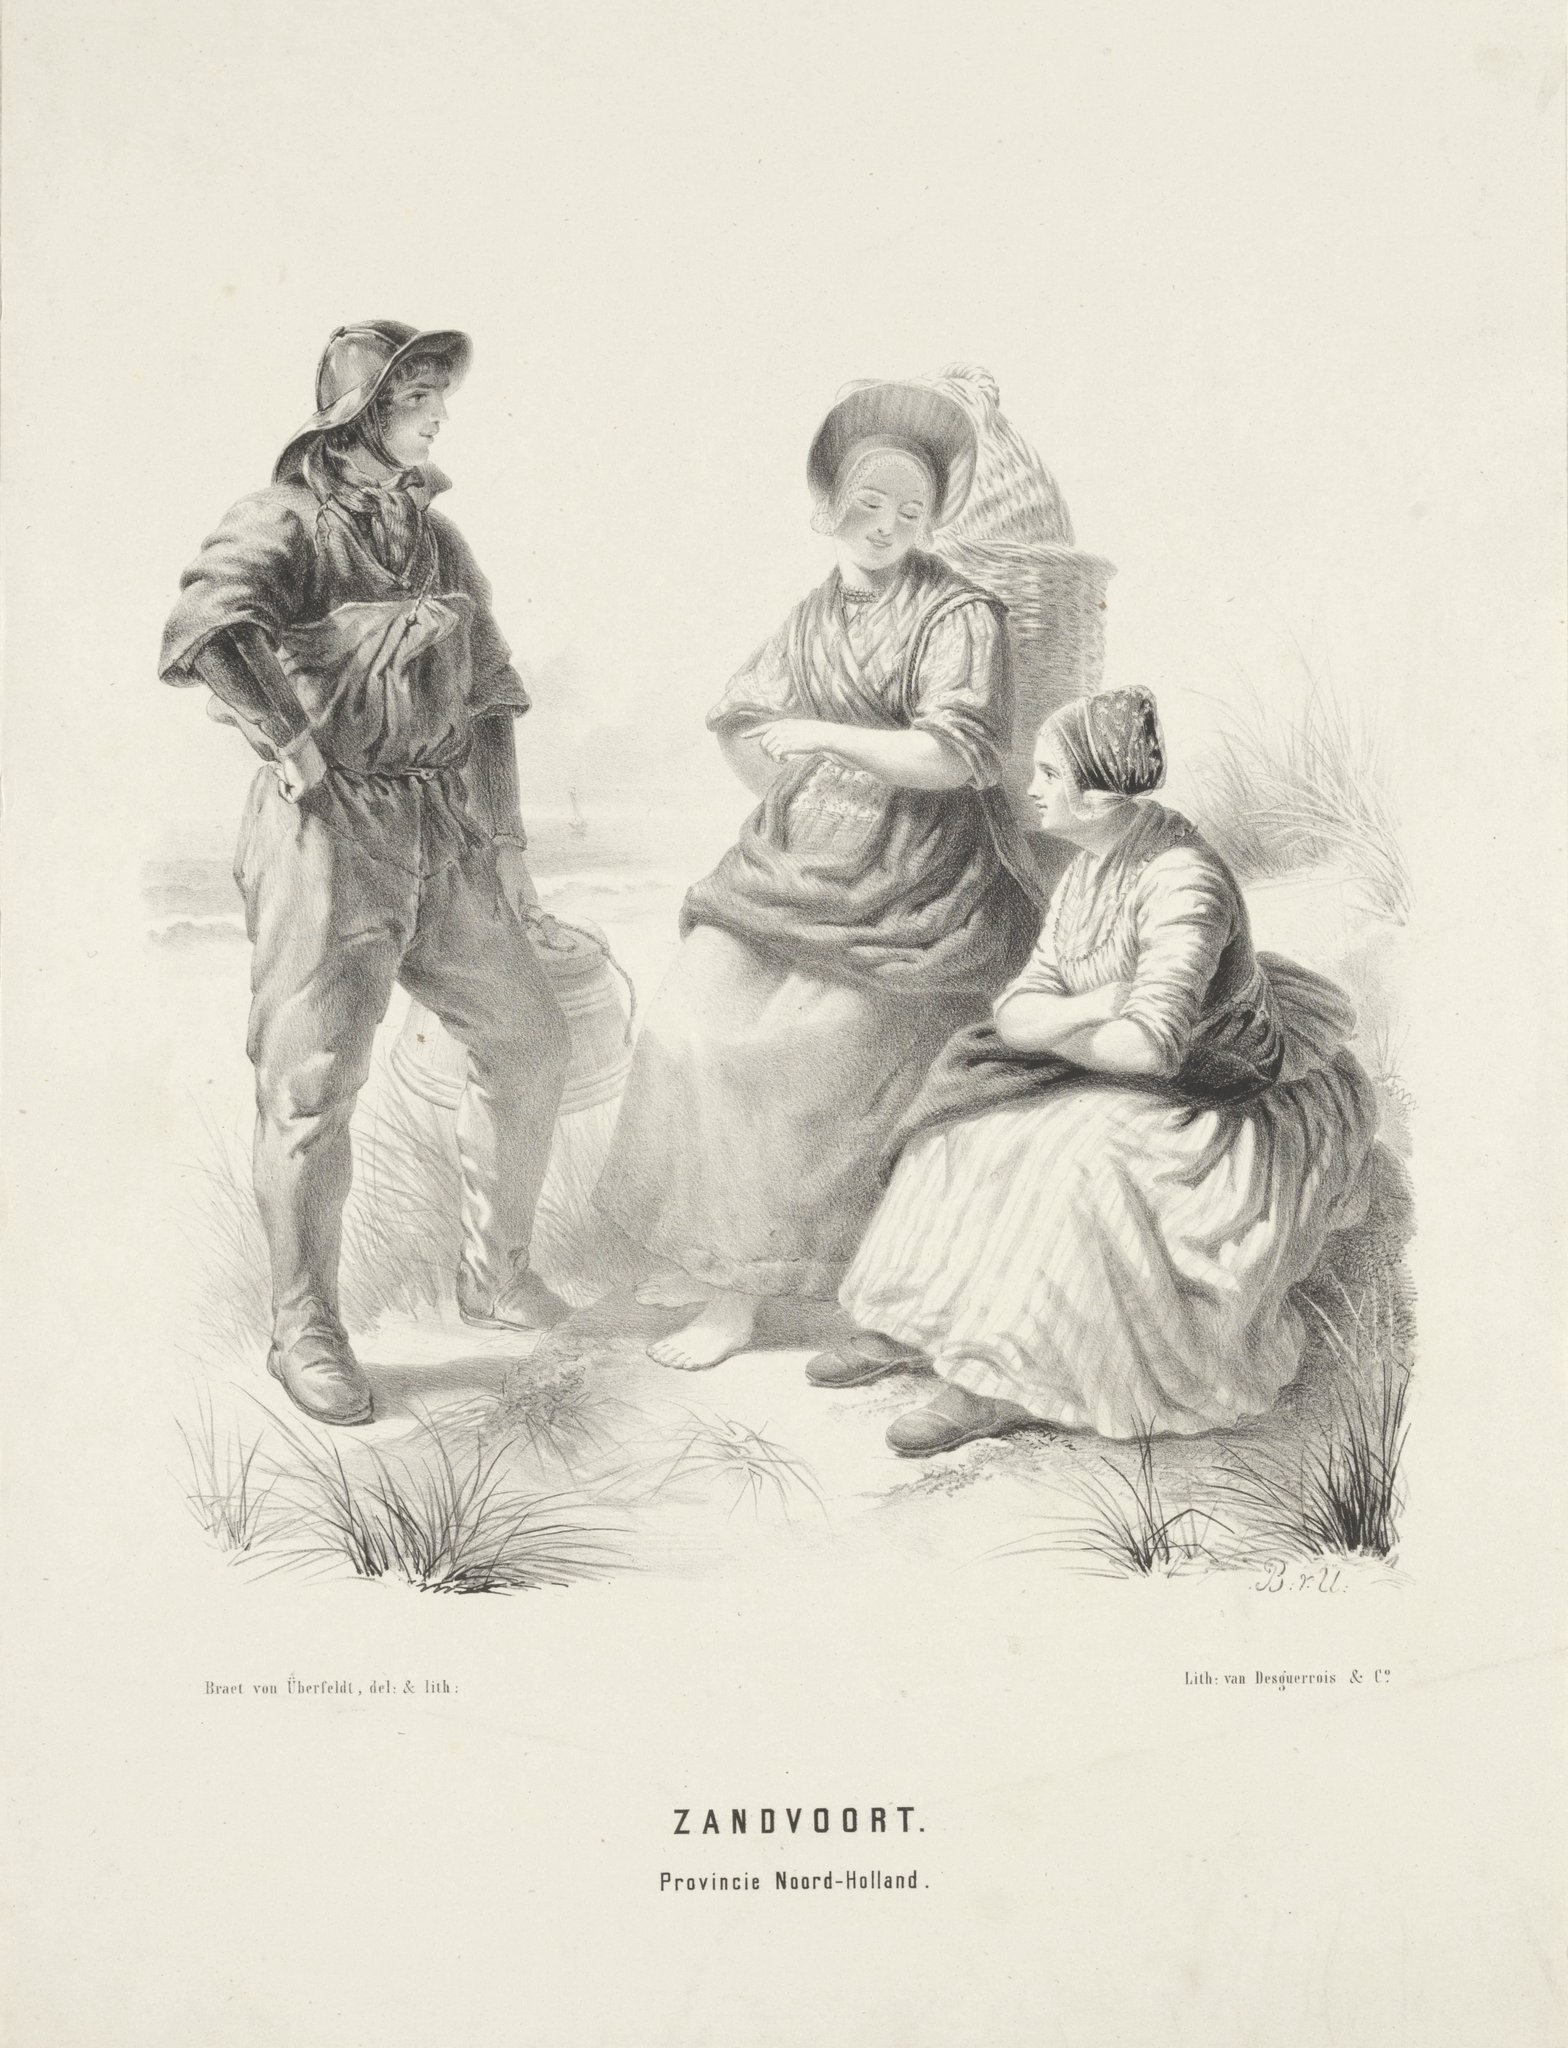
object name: print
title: Drie vissers op het strand bij Zandvoort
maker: jan braet von uberfeldt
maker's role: draughtsman, print maker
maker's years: 1807-1894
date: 1817-1894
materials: paper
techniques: lithograph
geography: netherlands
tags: carrying something in basket, bag, rucksack, etc., sitting on the ground - aa - female human figure, fisherman, dune coast (+ landscape with figures, staffage)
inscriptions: collector's mark: Lugt 2228, collector's mark: Lugt 2760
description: Een man en twee vrouwen staan en zitten in de duinen. Een vrouw heeft een rieten mand op haar rug.